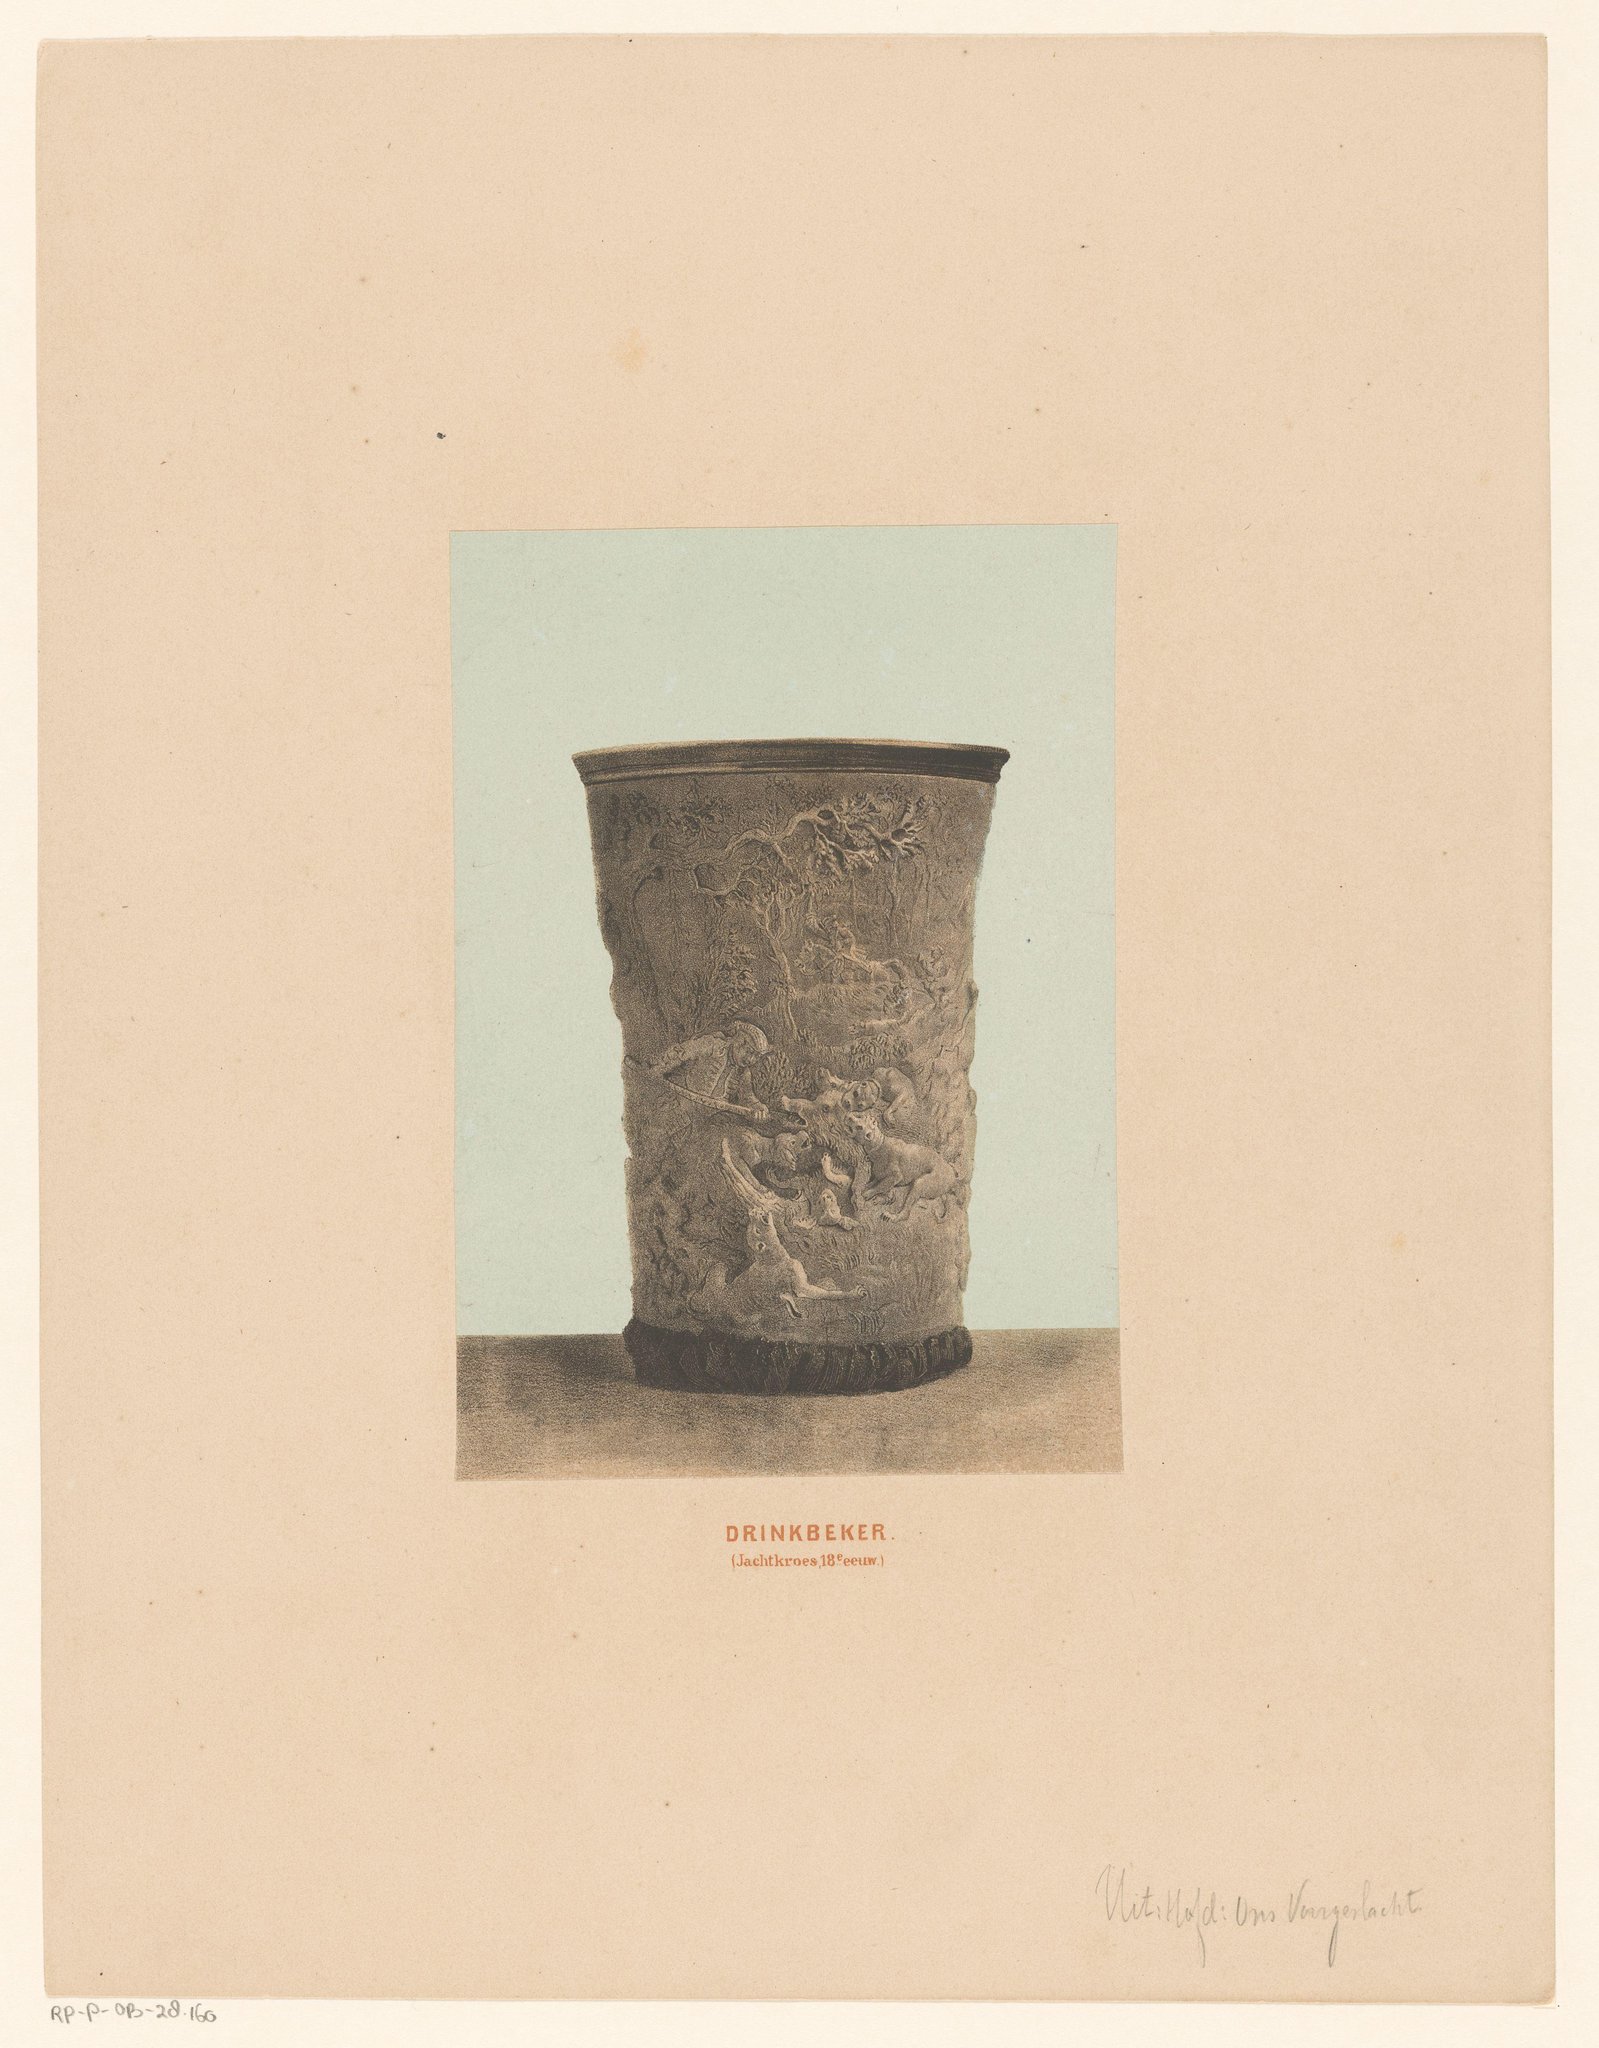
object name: print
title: Jachtkroes, 18e eeuw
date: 1857-1864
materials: paper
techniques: lithograph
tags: cup, hunt ~ mammals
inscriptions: collector's mark: Lugt 2228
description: Op de beker staat een tafereel in reliëf van een jager met zijn honden en een beer.